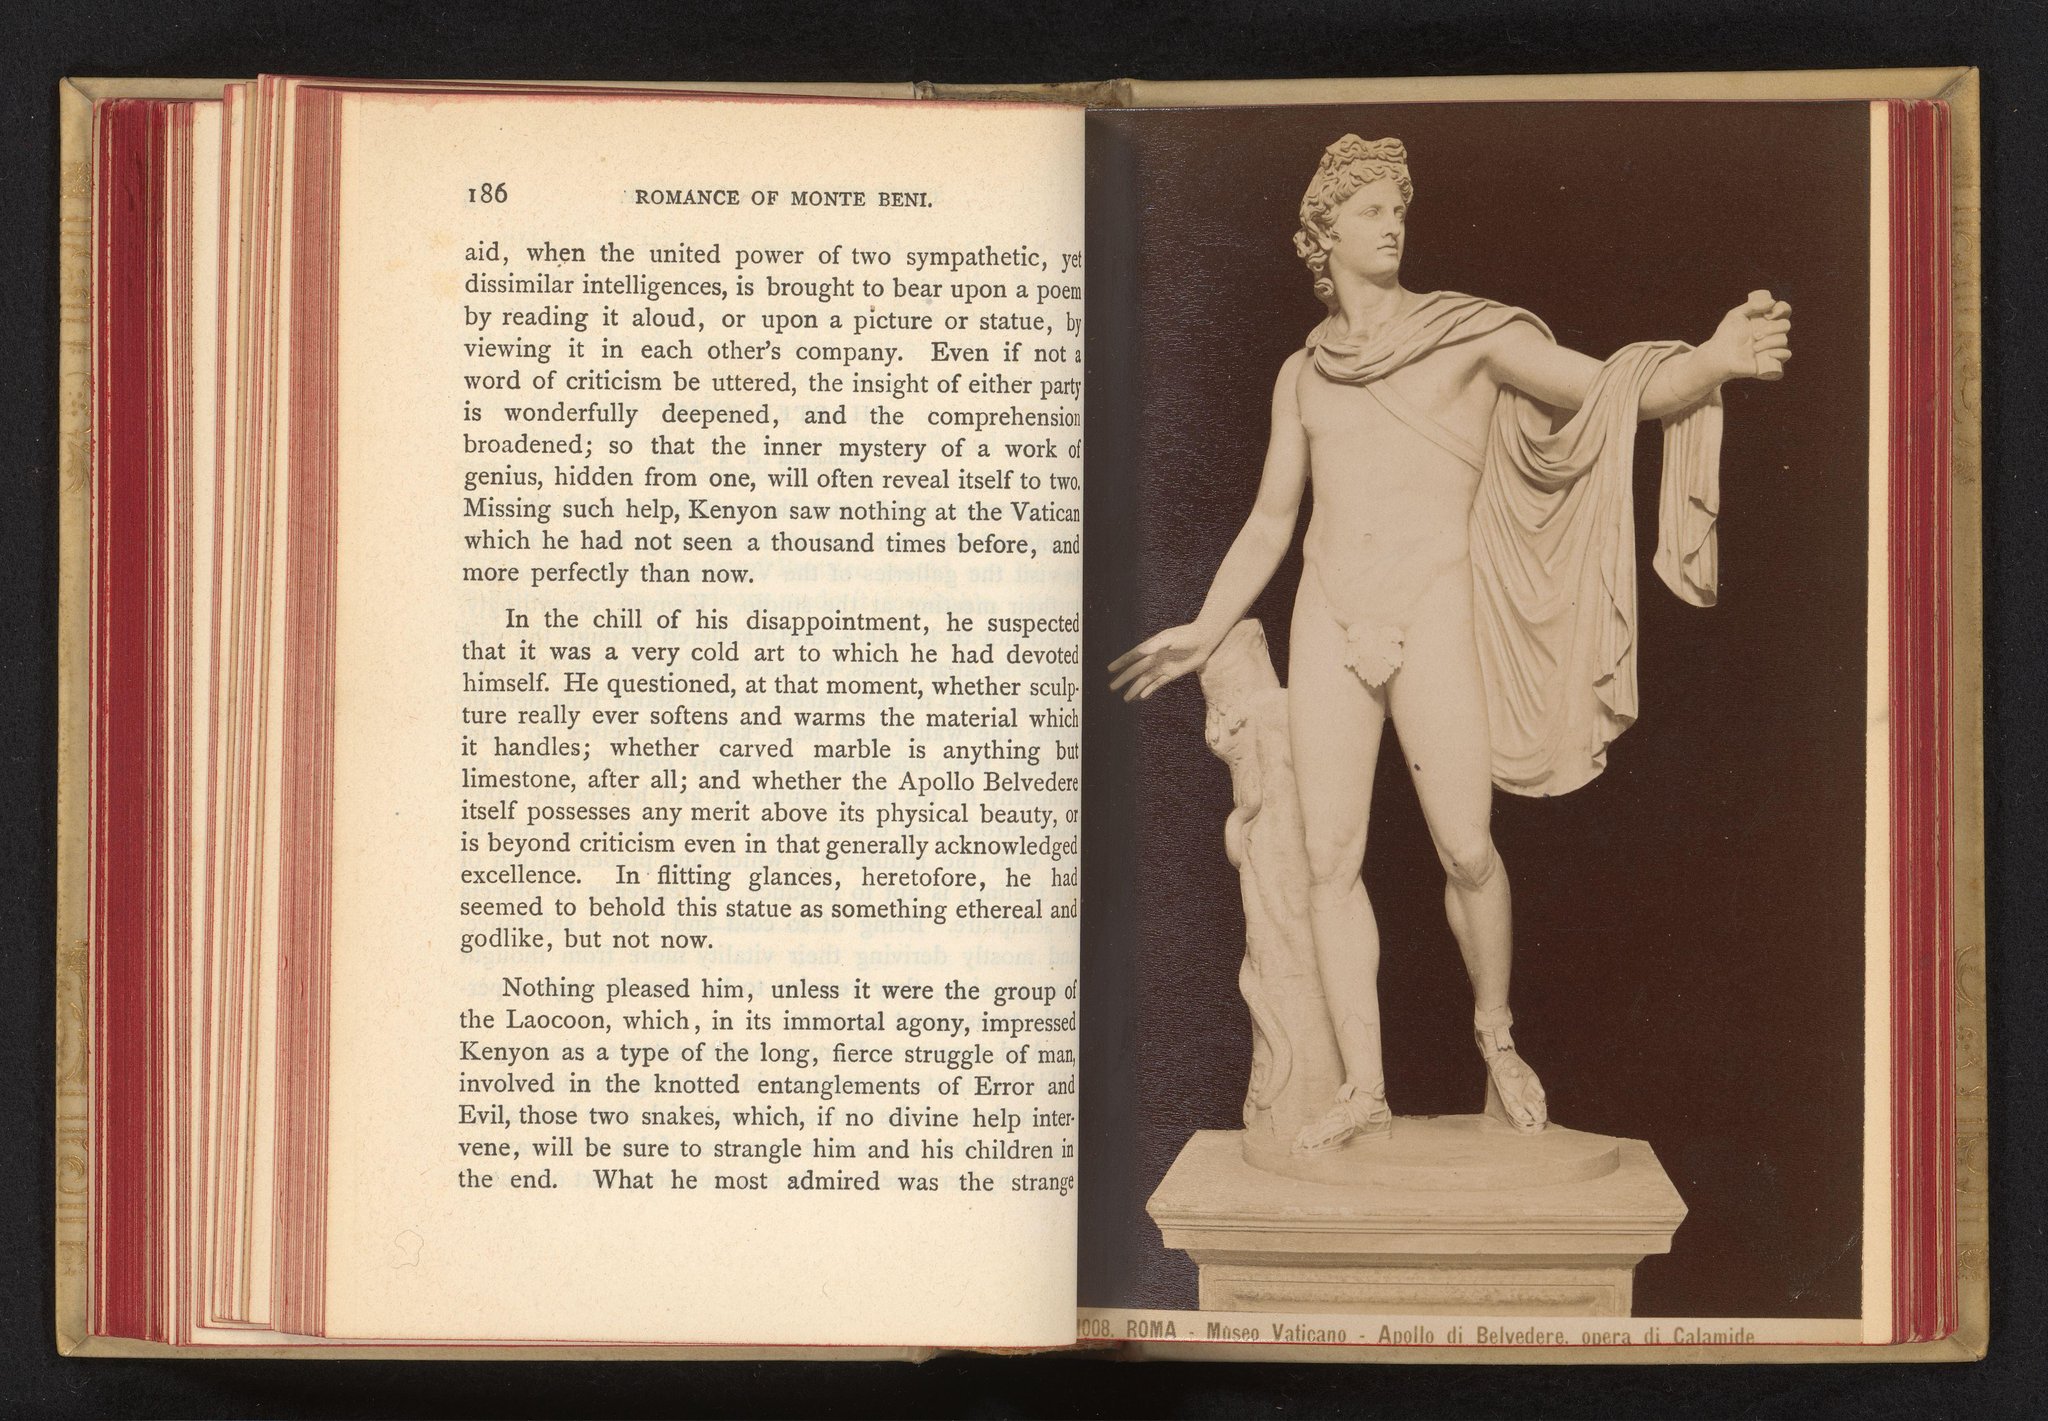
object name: page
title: Apollo van Belvedère in de Vaticaanse Musea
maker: Anonymous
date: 1855-1860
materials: paper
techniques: albumen print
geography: vatican museums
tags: (story of) apollo (phoebus), sculpture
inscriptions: number: ‘1008.’